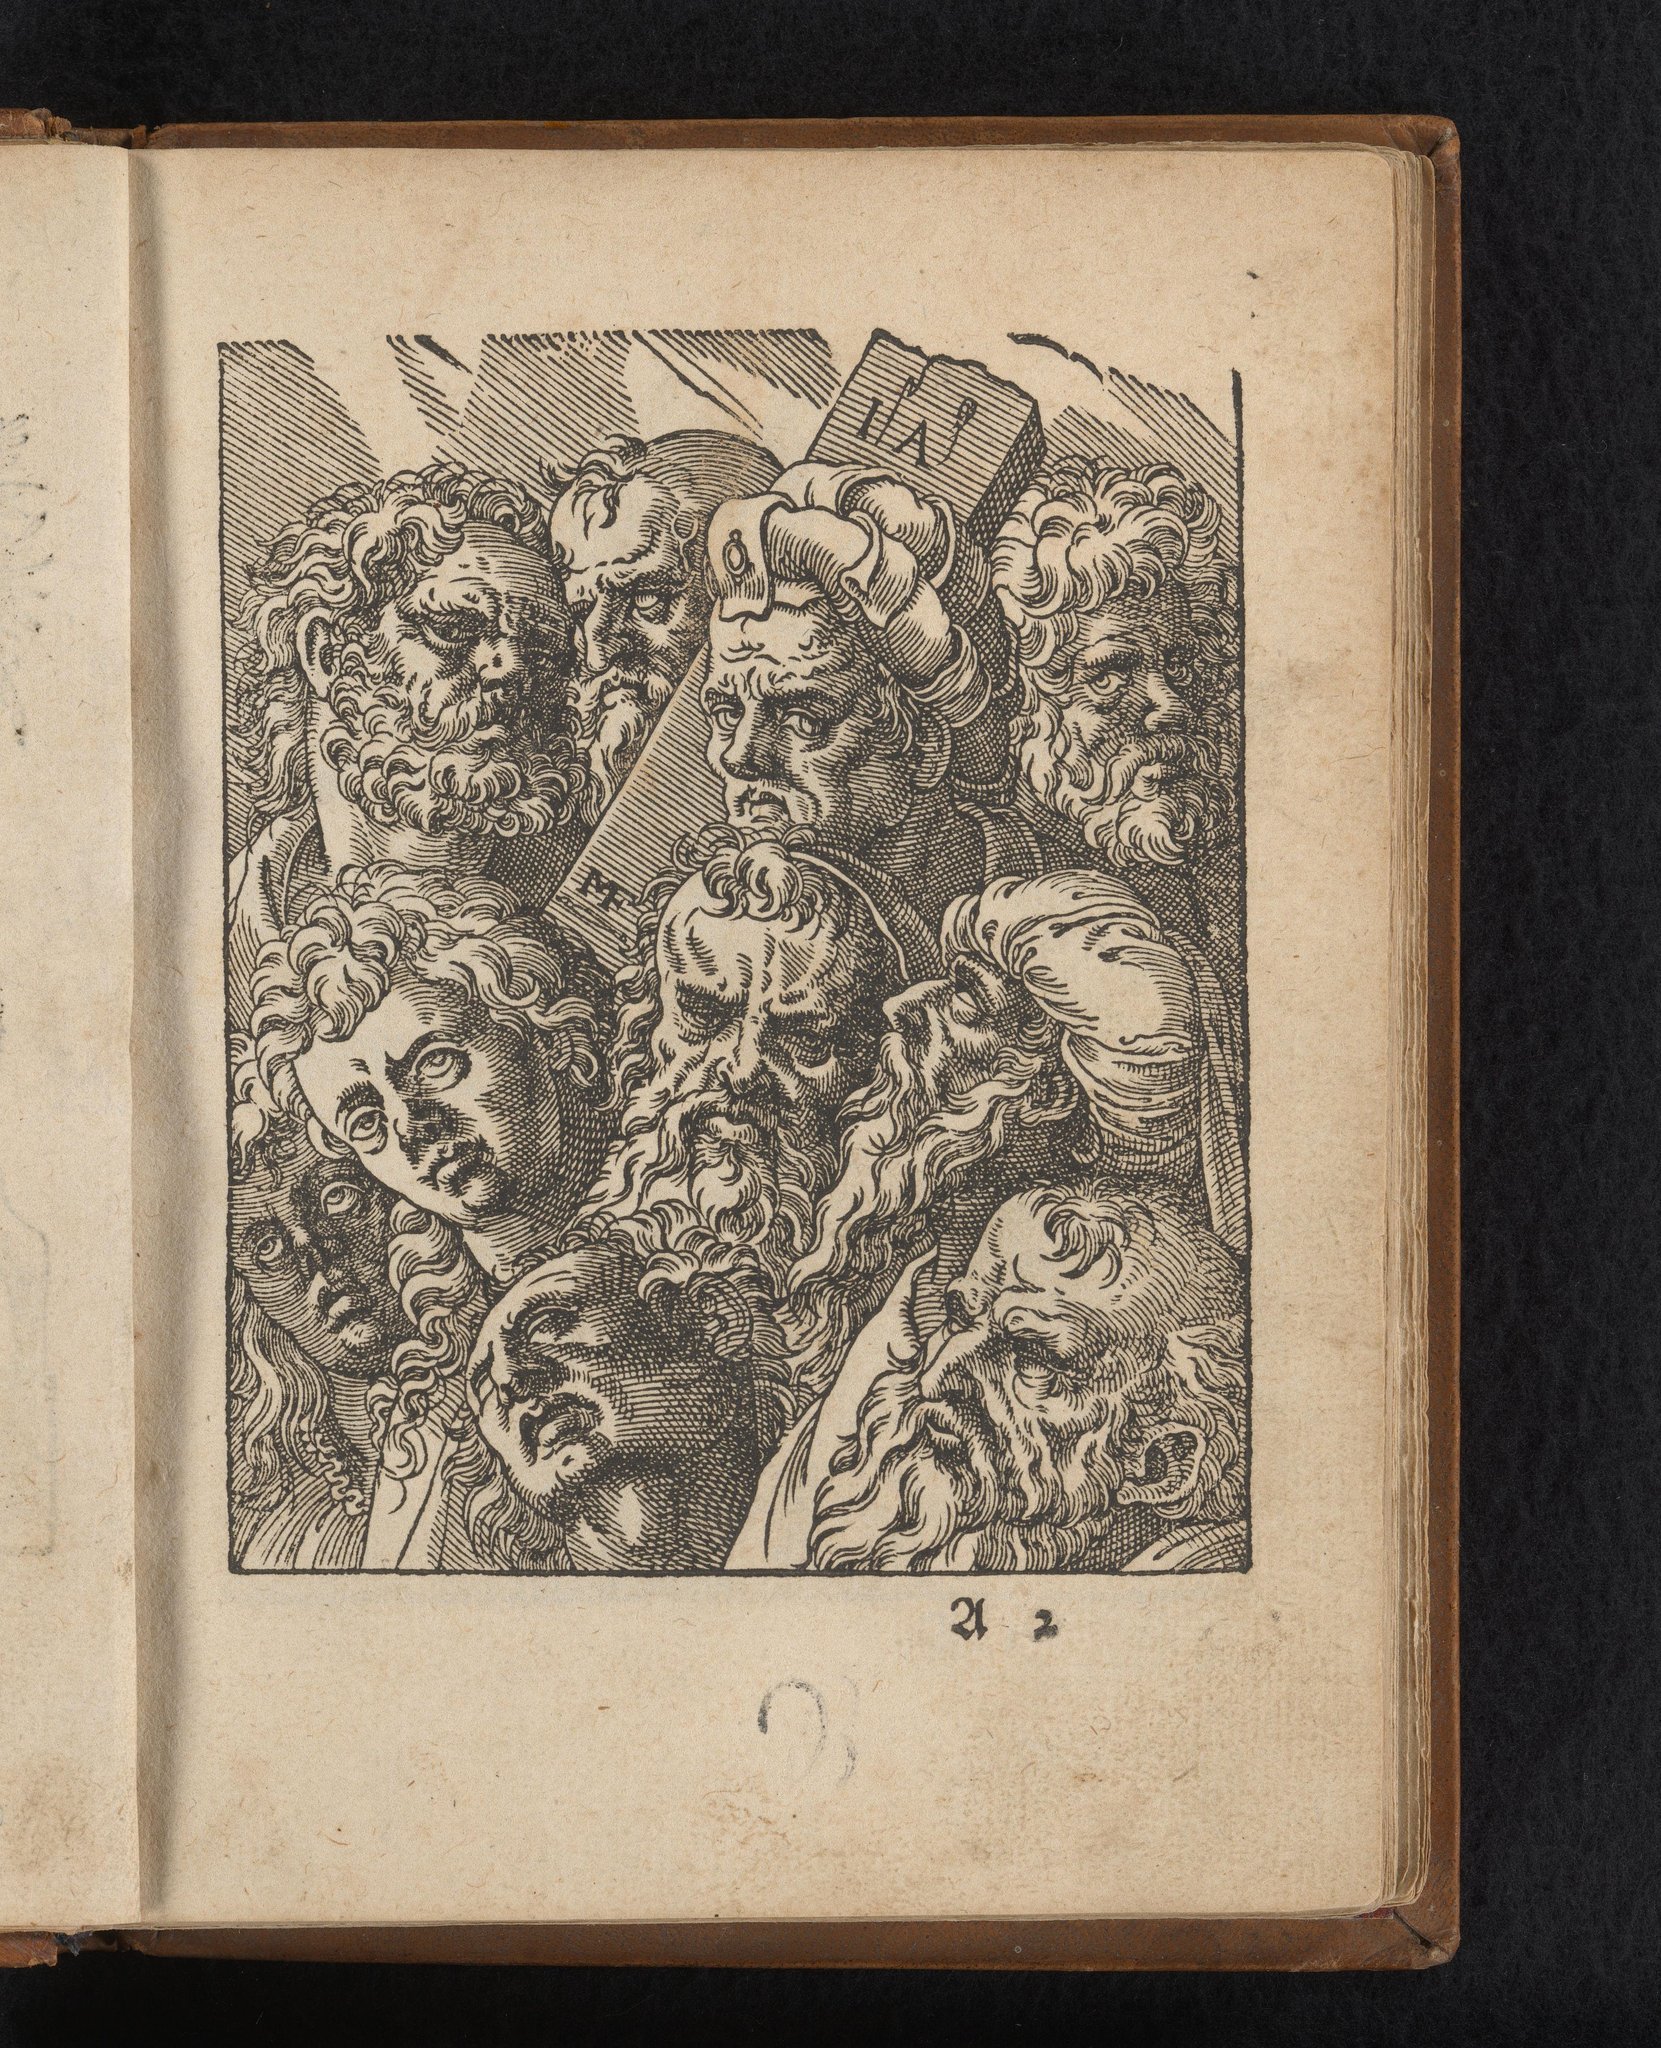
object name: print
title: Mannenkoppen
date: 1578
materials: paper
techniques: woodcut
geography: nuremberg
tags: head (human), postures of the head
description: Tien hoofden van mannen. Onderdeel van het modelboek Enchiridion artis pingendi, fingendi & sculpendi met 108 figuren bedoeld voor beginnende schilders, beeldhouwers en prentmakers.